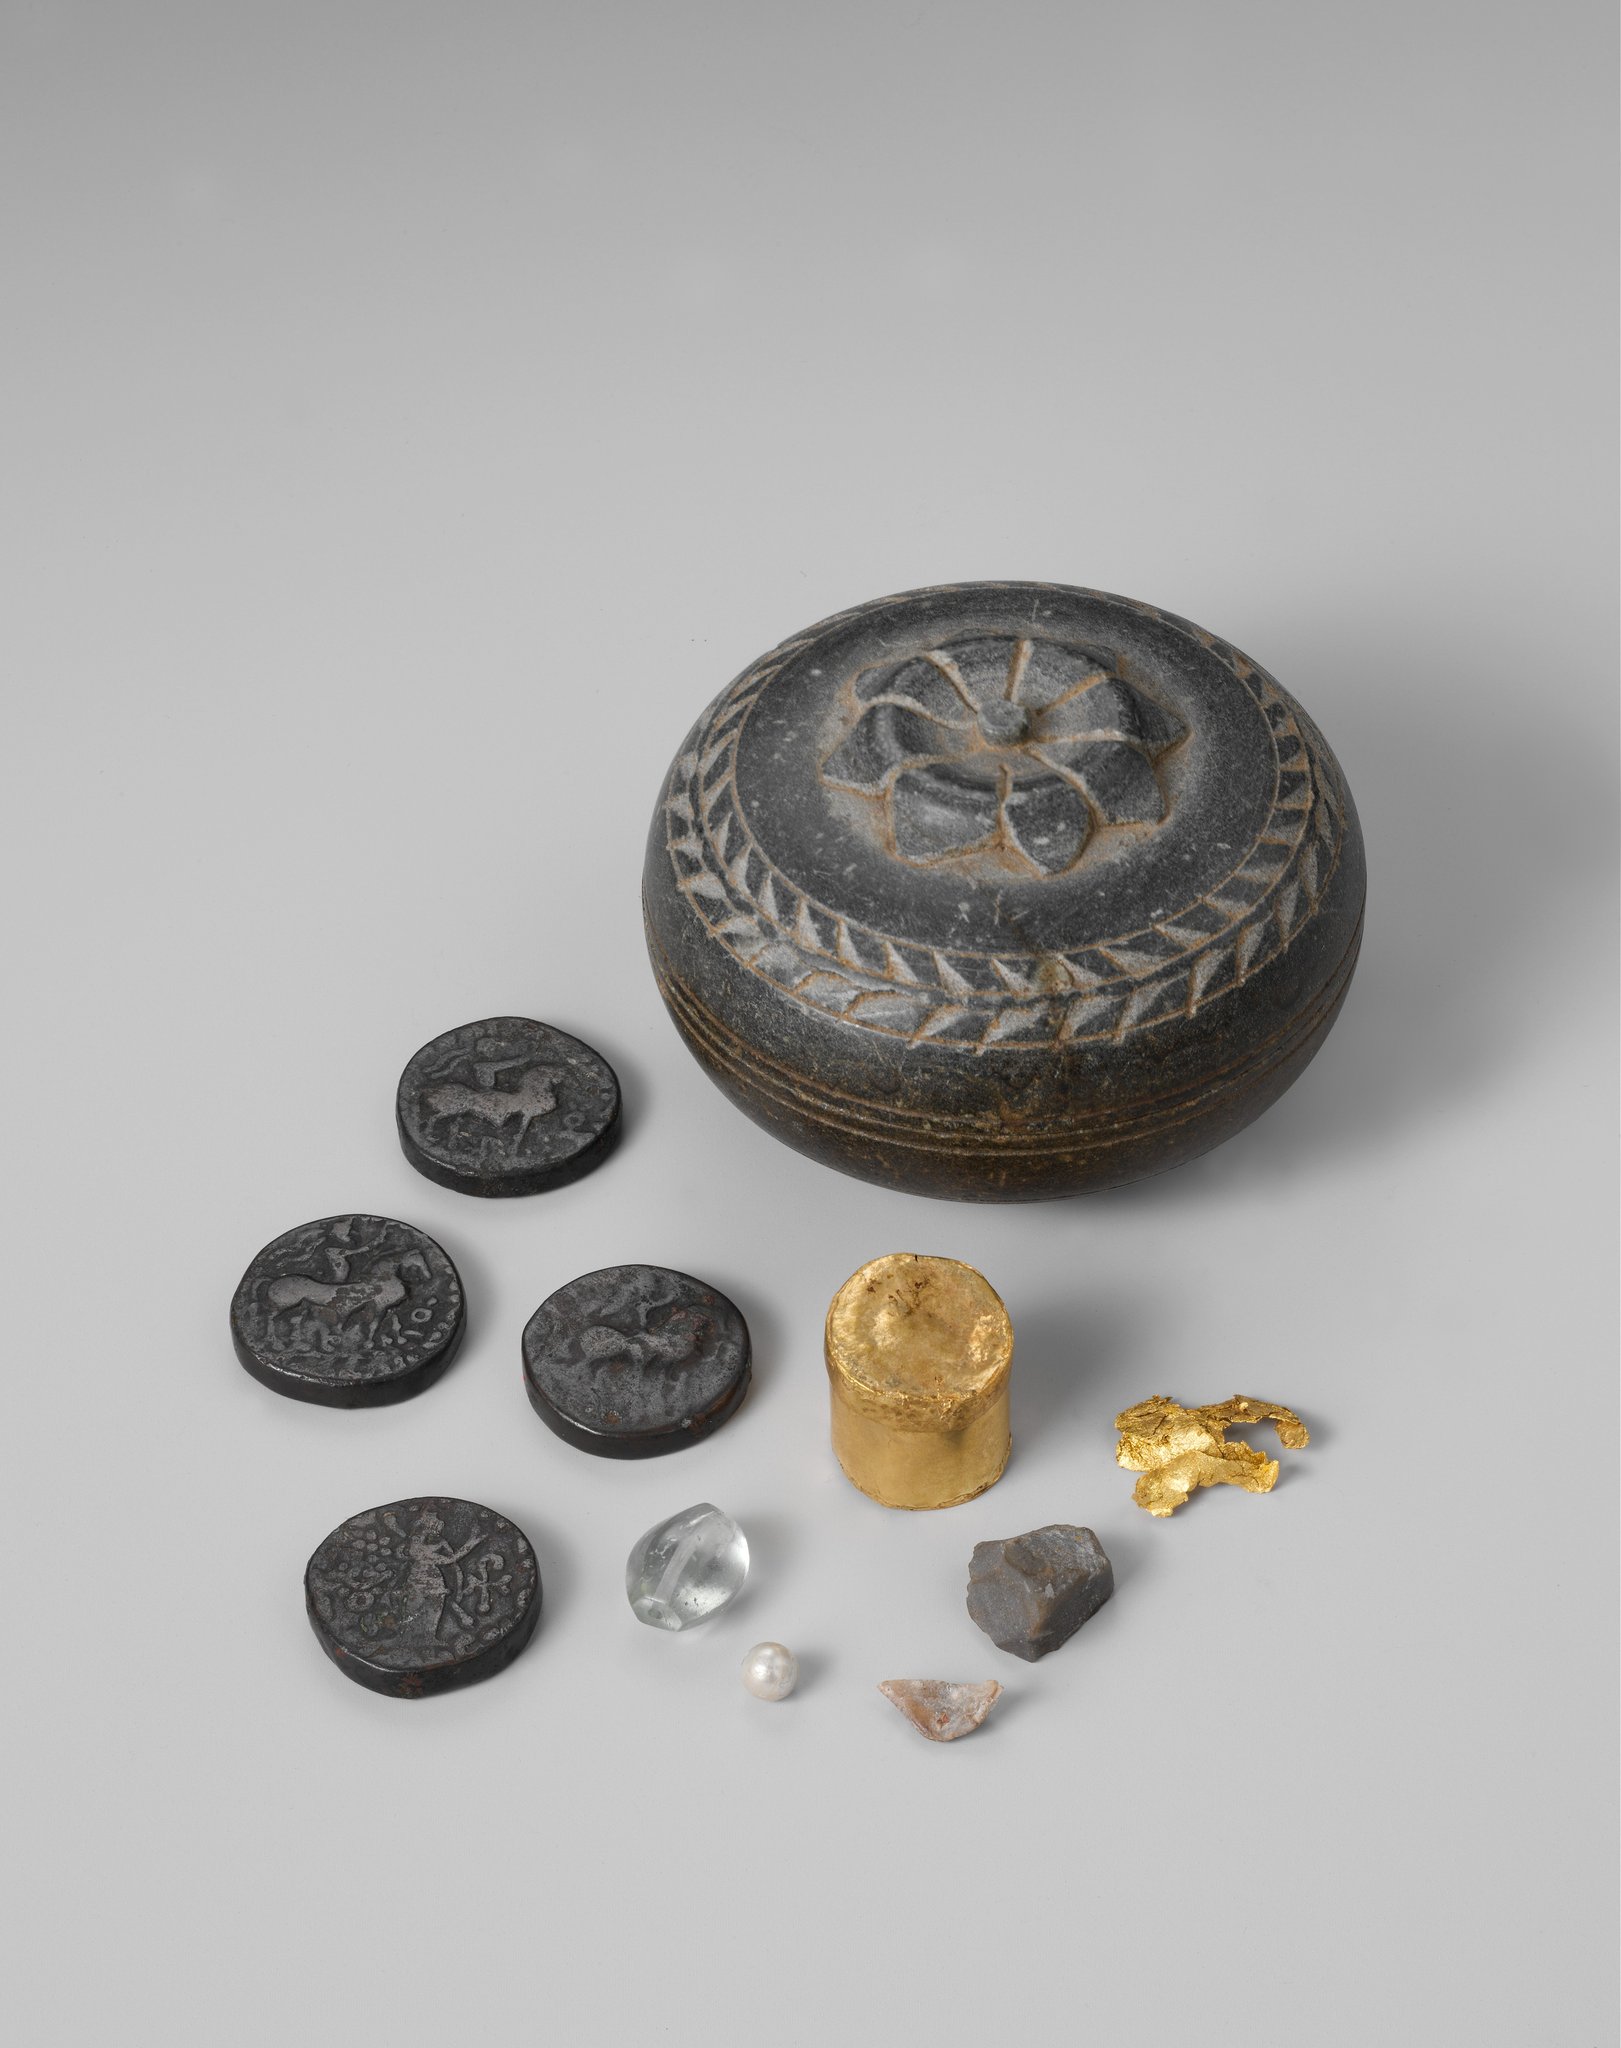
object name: reliquary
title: Reliquary with Contents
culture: gandhara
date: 1-300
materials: gold leaf, stone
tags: gandhara